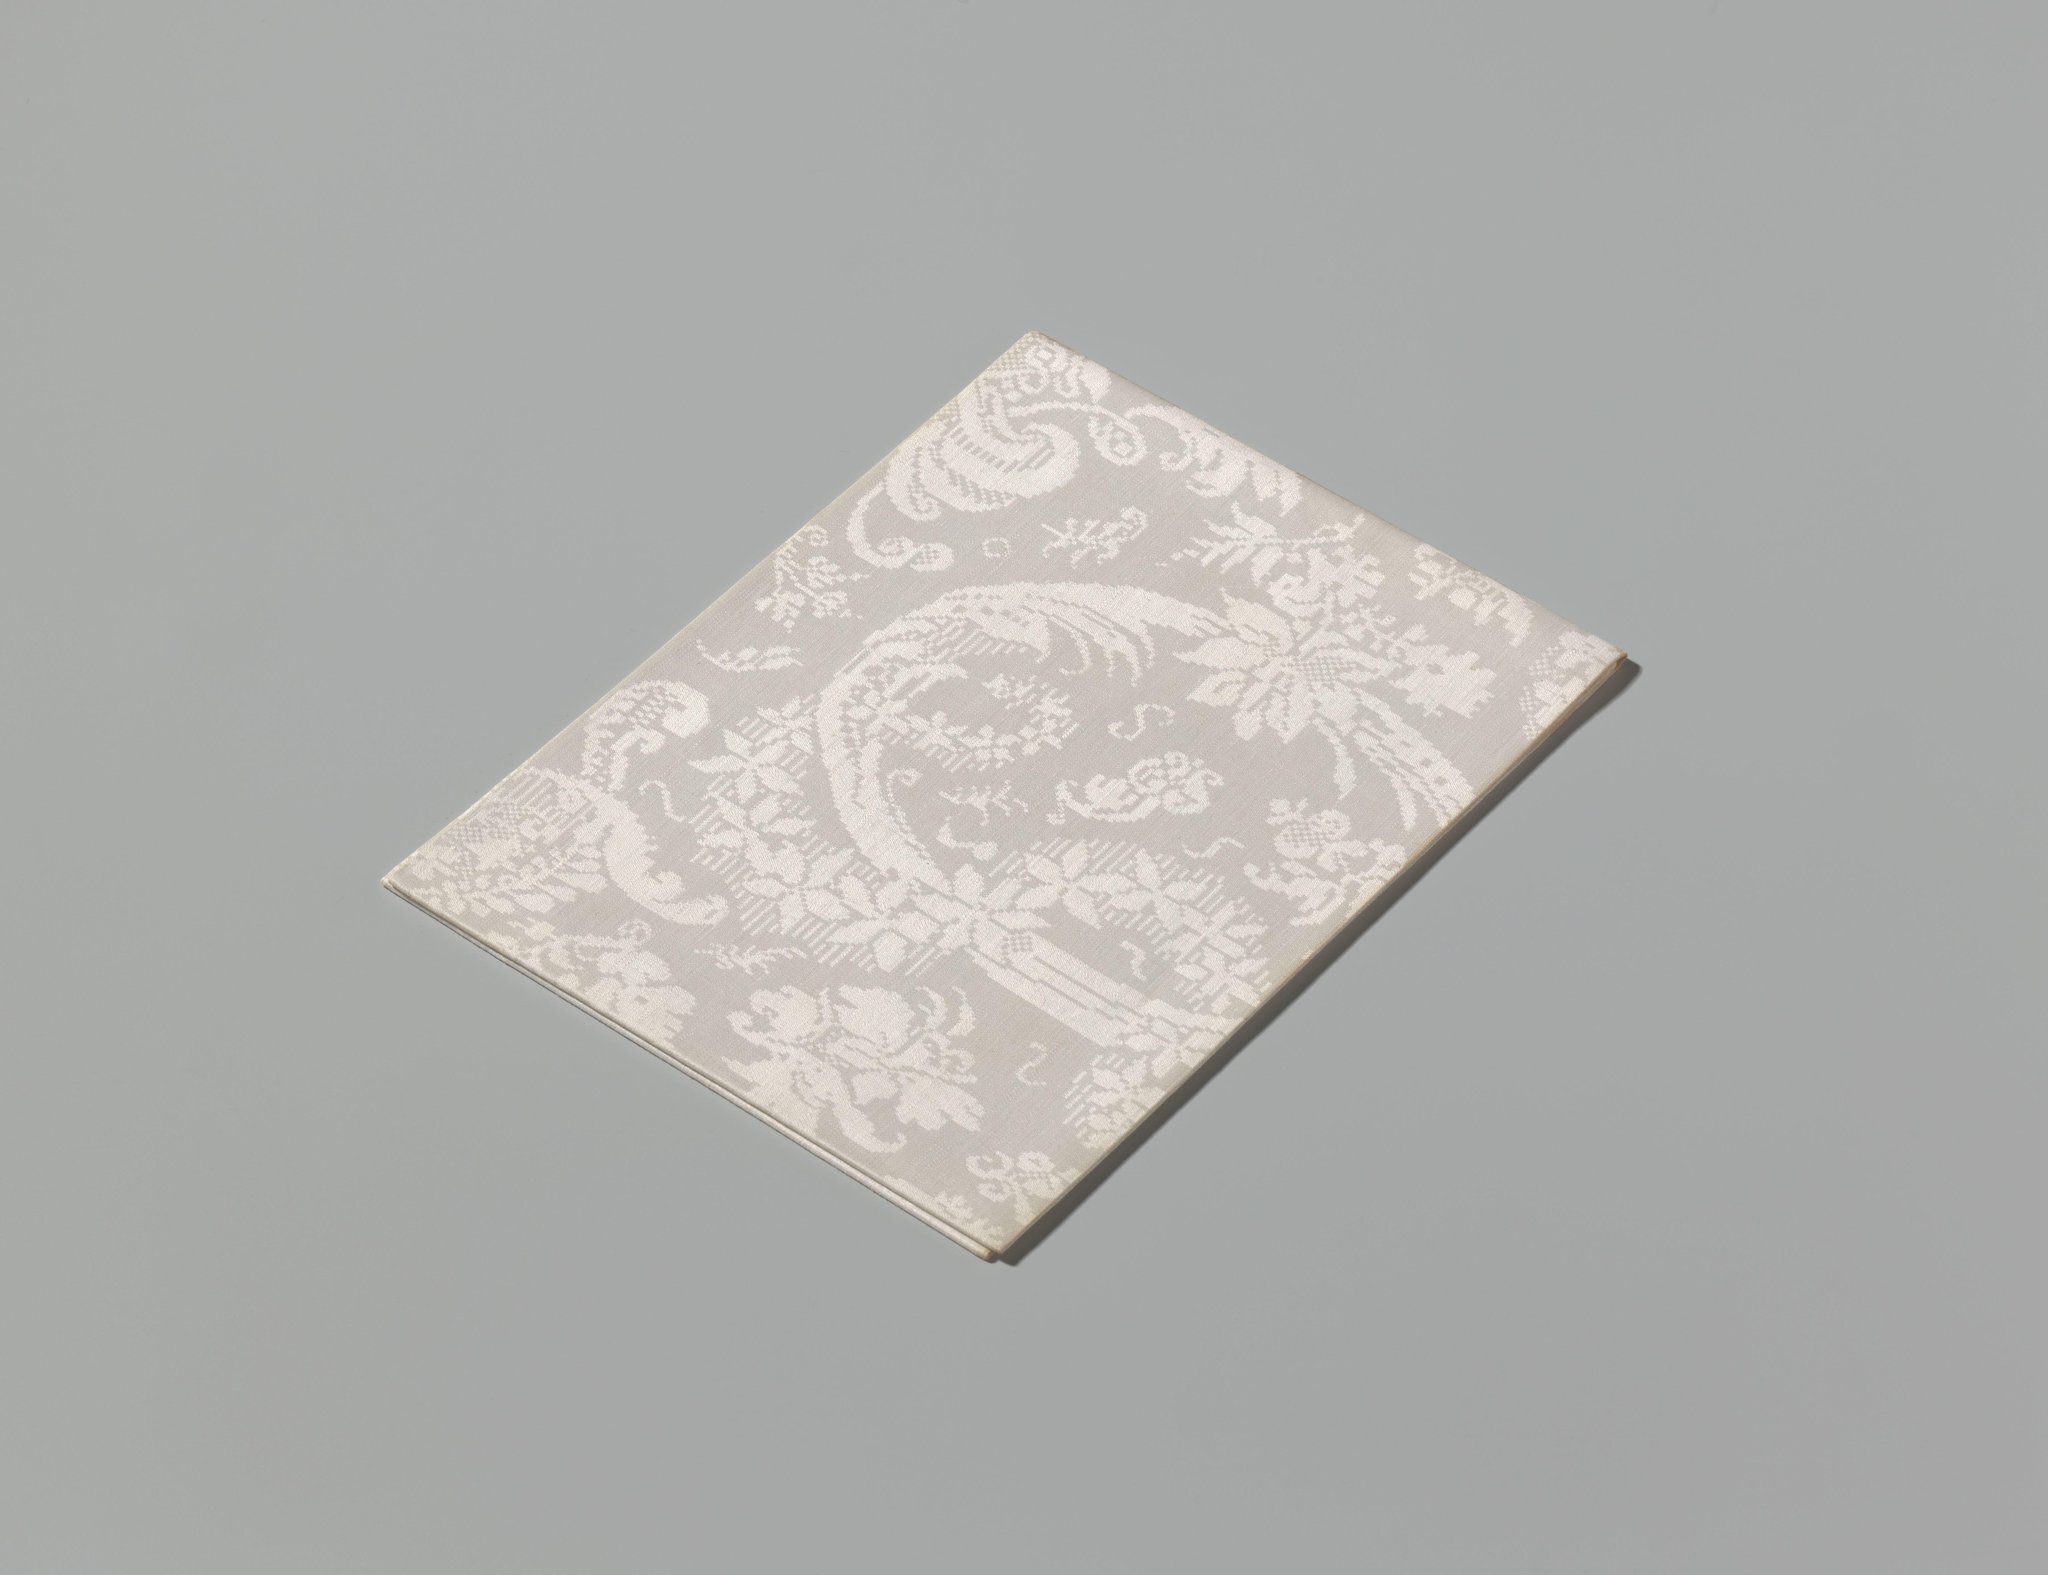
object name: napkin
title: Servet van wit linnendamast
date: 1692-1700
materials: linen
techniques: damask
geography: northern netherlands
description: Wit linnendamasten servet met patroon van voluten, merk IS 24.